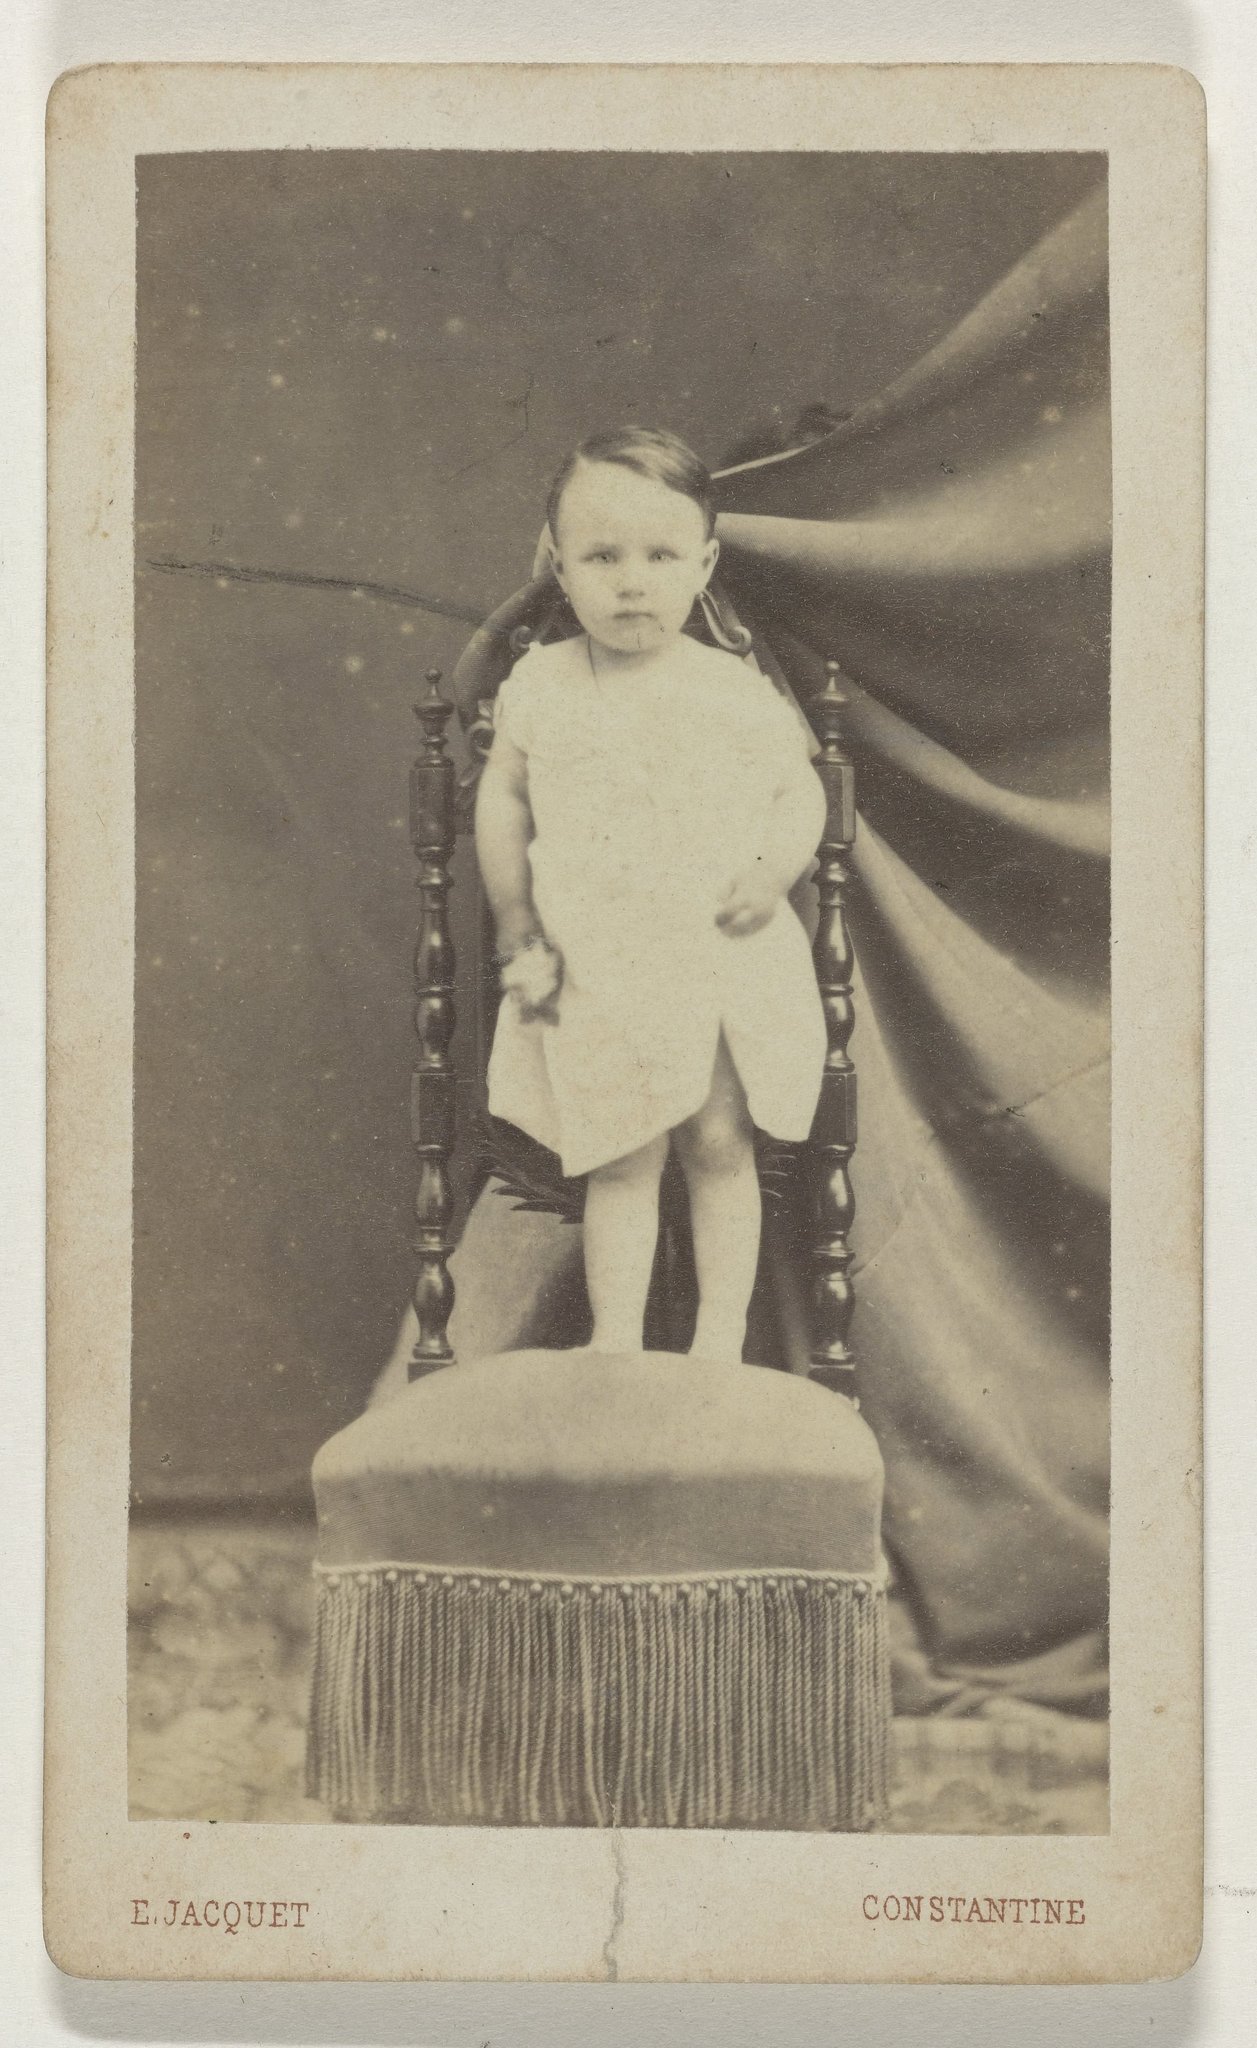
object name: carte de visite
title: Portret van een kind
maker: eugène jacquet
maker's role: fotograaf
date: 1870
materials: cardboard, paper, photographic support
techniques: albumen print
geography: constantine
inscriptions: address: ‘Ancienne Maison Sarrault/Eug. Jacquet Succr/Constantine’, annotation: ‘Jean.. La..daire/2 juin 70(21 mois)’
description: Klein kind van bijna 2 jaar oud, staand op een stoel waarachter een gordijn.